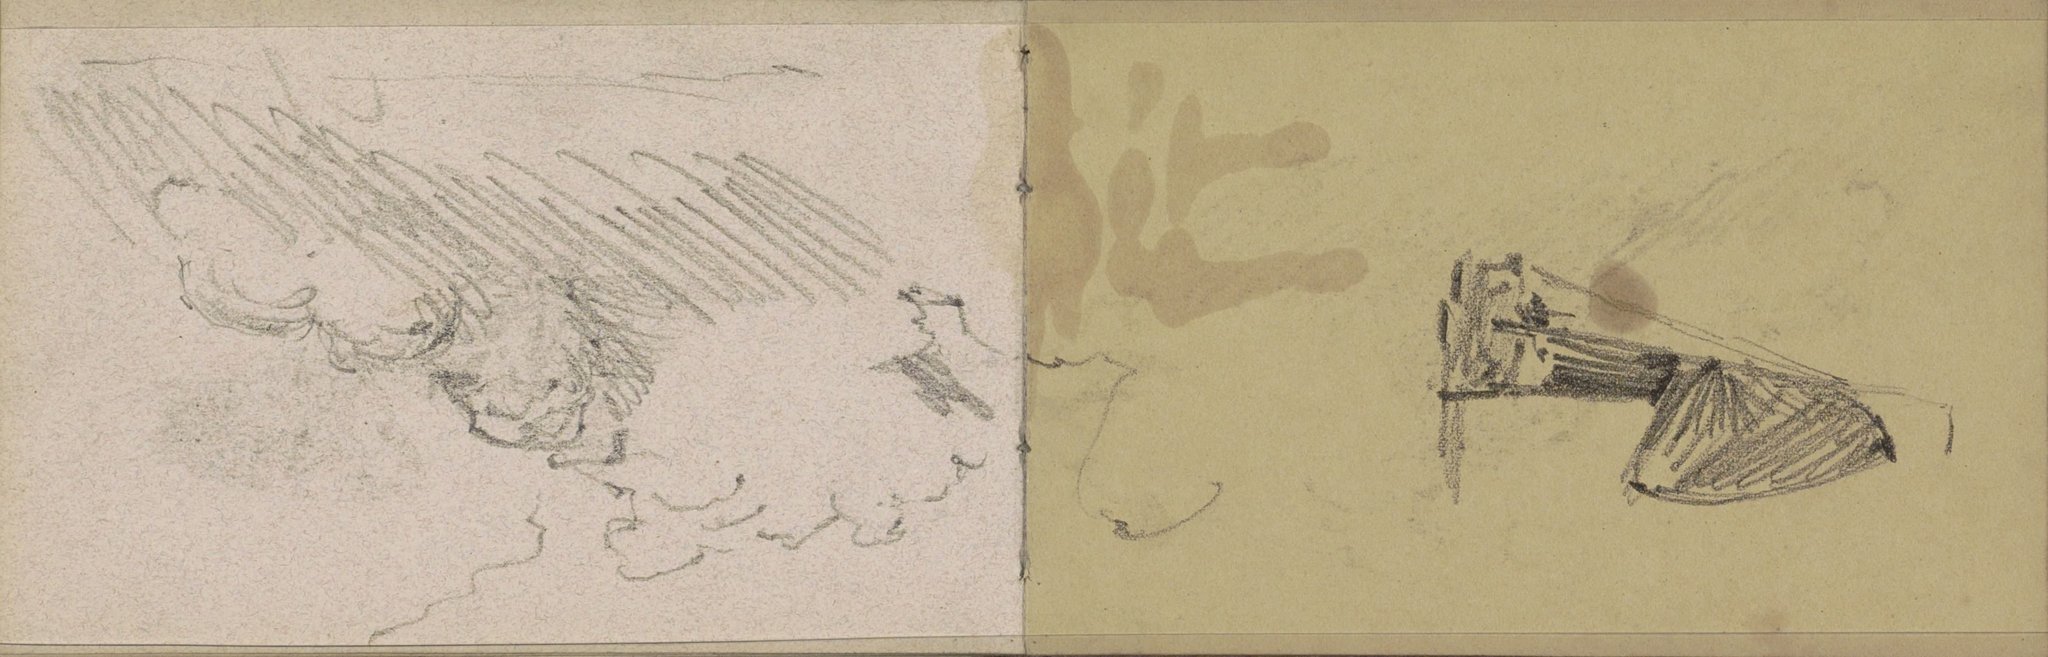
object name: sketchbook leaf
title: Wolken en een studie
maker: george clausen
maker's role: draughtsman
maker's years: 1852-1912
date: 1875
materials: paper, pencil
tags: clouds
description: Blad 28 verso en 29 recto uit een schetsboek met 38 bladen.